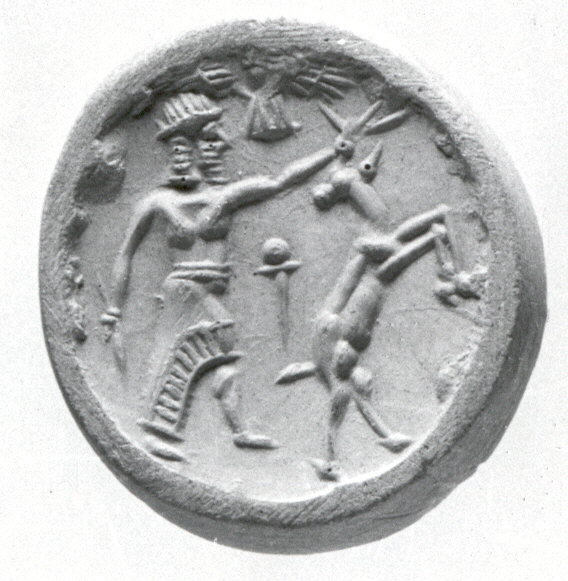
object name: stamp seal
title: Stamp seal (conoid) with two-figure contest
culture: assyro-babylonian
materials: stone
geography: mesopotamia or syria or cyprus (?)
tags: animals